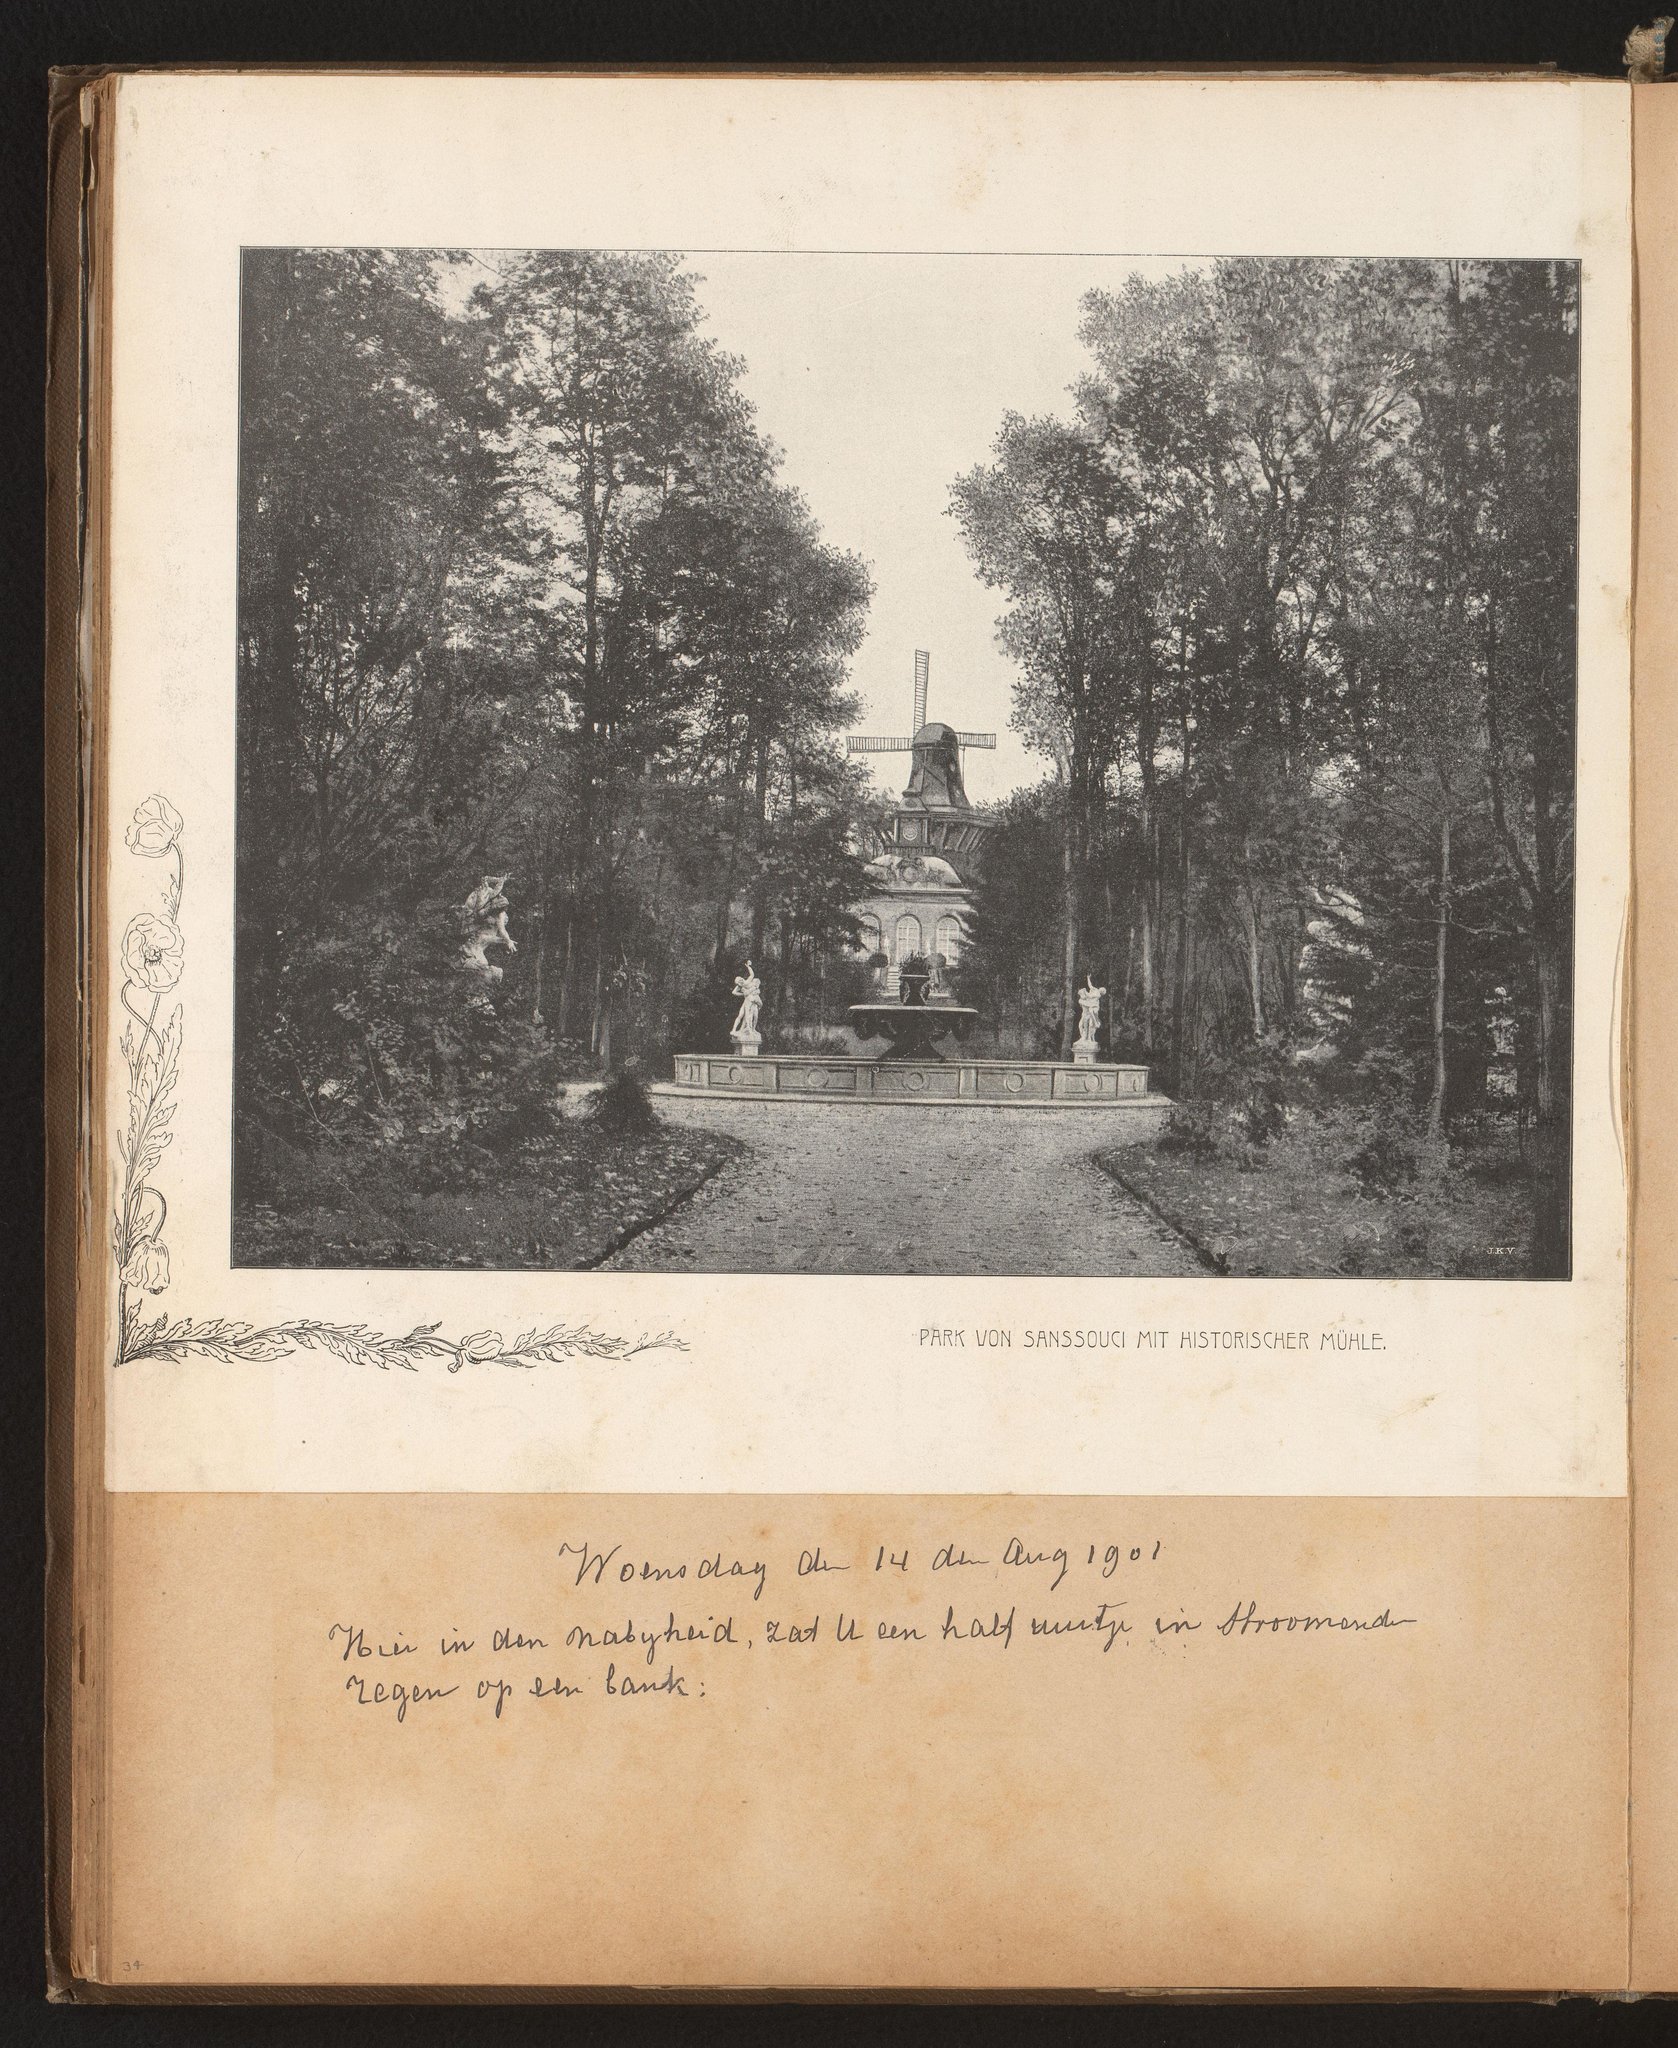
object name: album leaf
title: Fontein en molen in het park van Schloss Sanssouci, Potsdam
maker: Anonymous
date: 1896-1901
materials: paper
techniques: autotype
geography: potsdam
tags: ornamental fountain, windmill, public gardens, park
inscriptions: inscription: ‘Woensdag den 14den Aug 1901/ Hier in den nabijheid, zat U een half uurtje in stroomende/ regen op een bank.’, title: ‘Park von Sanssouci mit historischer Mühle.’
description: Deze fotomechanische afdruk maakt deel uit van een album.